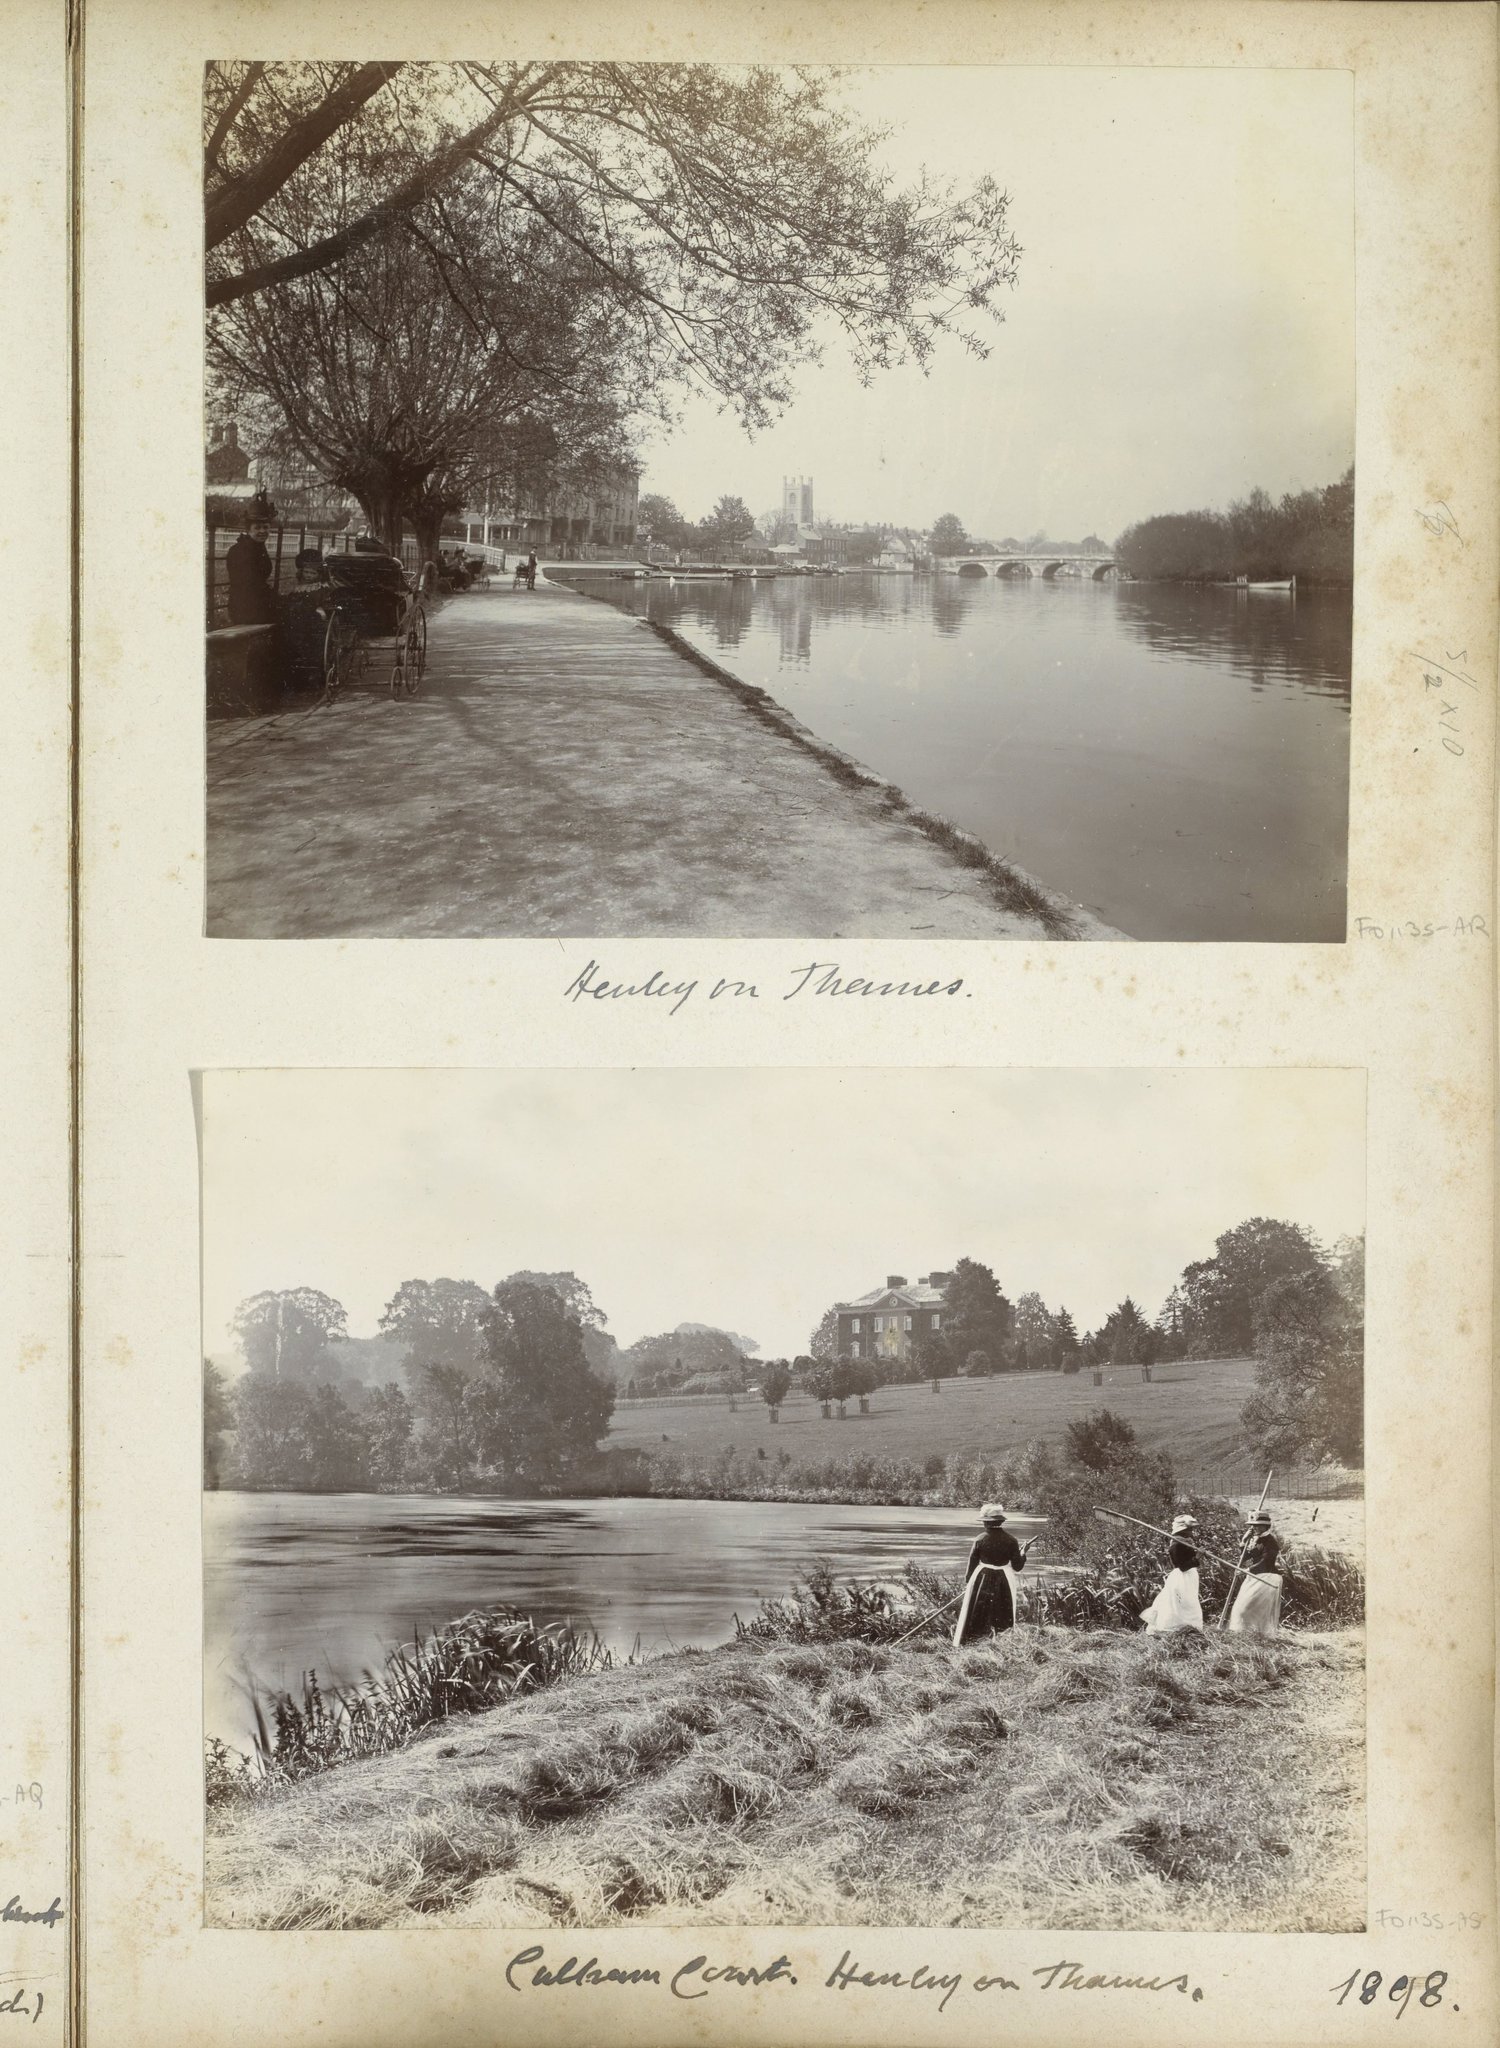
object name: album leaf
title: Gezicht op Henley-on-Thames vanaf een pad langs de rivier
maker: Anonymous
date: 1898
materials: paper, photographic support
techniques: daylight paper print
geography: henley-on-thames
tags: prospect of village, silhouette of village, road, path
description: Onderdeel van Reisalbum met foto's van bezienswaardigheden in Engeland en Frankrijk.